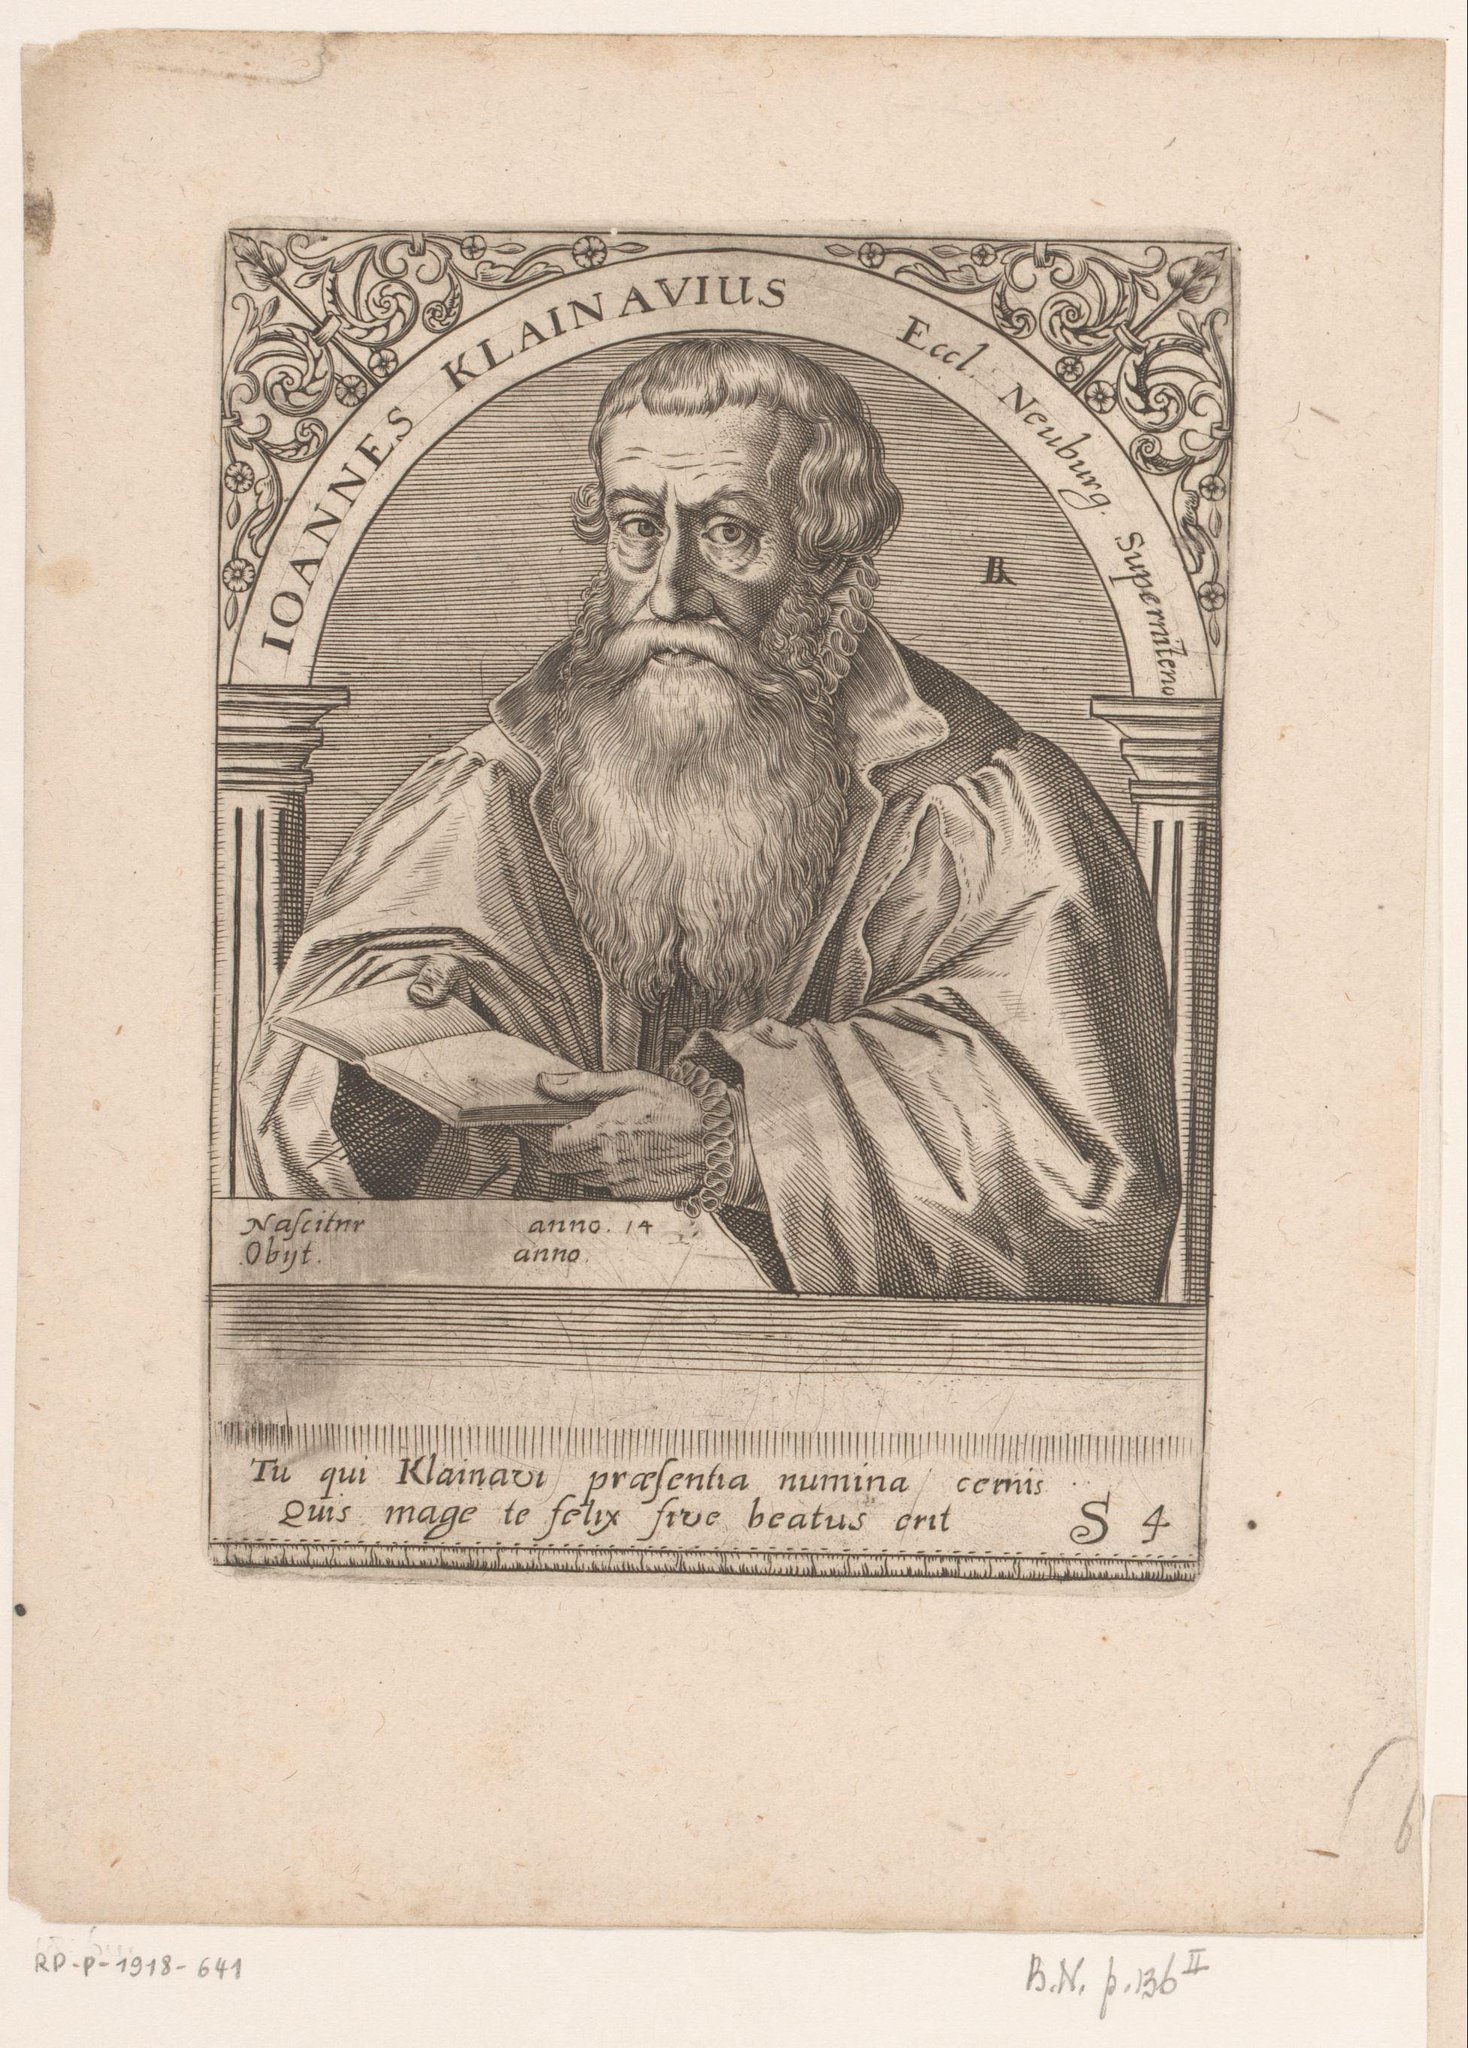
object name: print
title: Serie portretten van vijftiende- en zestiende-eeuwse geleerden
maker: robert boissard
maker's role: print maker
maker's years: 1570-1611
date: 1597-1599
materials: paper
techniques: engraving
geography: france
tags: historical persons, book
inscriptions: collector's mark: Lugt 2233